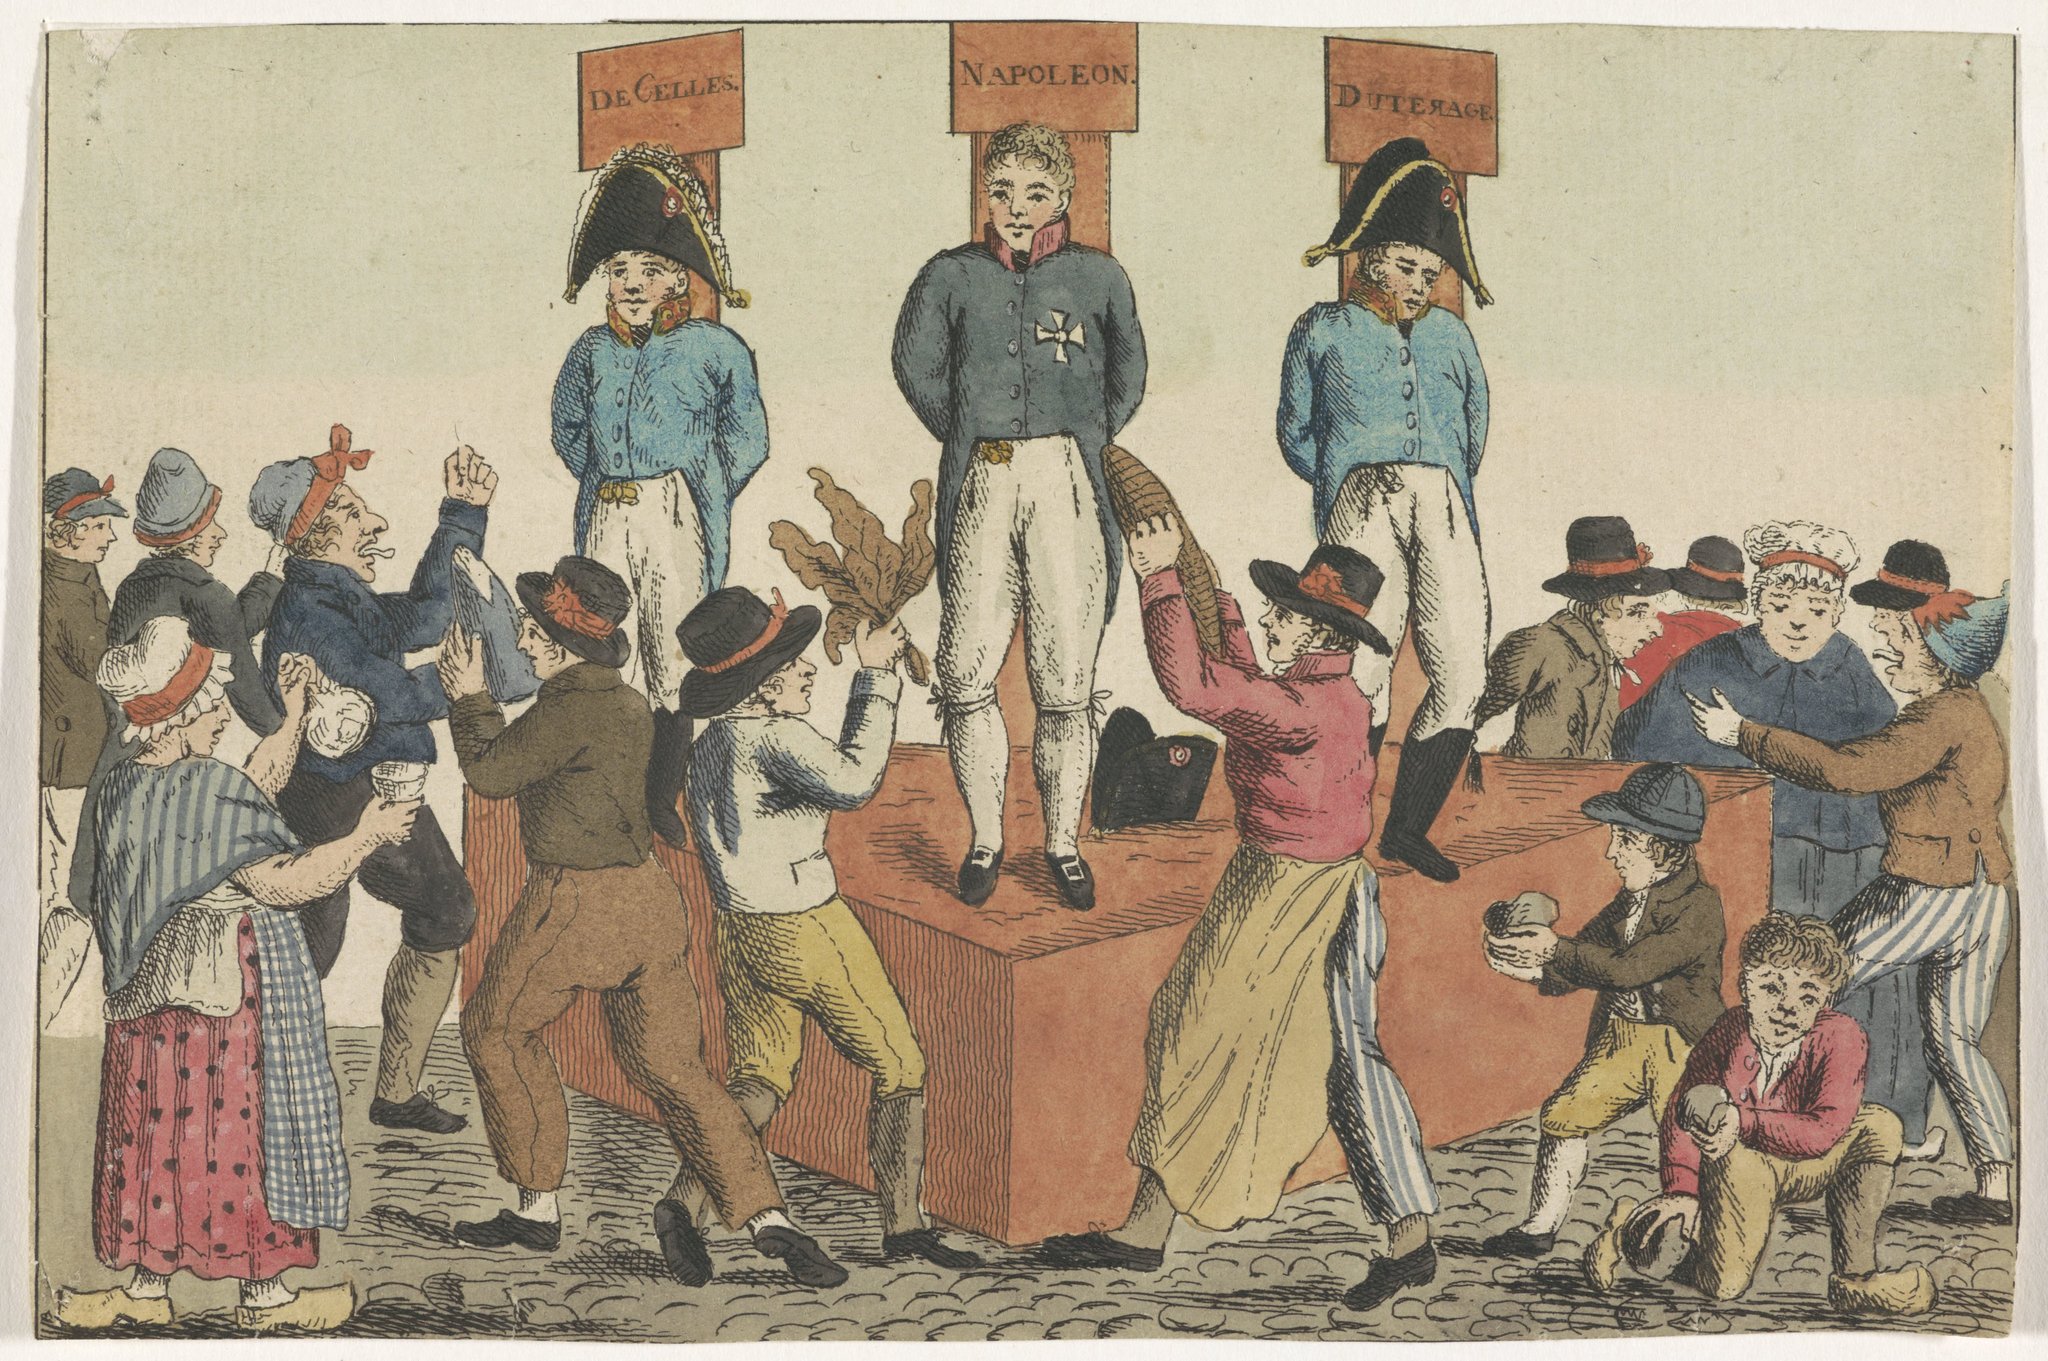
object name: print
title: Napoleon, De Celles en Duterage aan de schandpaal, 1813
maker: Anonymous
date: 1813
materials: paper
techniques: etching, hand coloring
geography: netherlands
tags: napoleon i (emperor of the french), in the pillory, in the stocks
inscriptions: collector's mark: Lugt 2228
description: Spotprent op Napoleon, mogelijk in verband met de afschaffing van accijnzen (regie-tabak en brood?) met het vertrek van de Fransen uit Nederland in 1813. Podium waarop prefect Antoine de Celles, keizer Napoleon en Duterage aan schandpalen gebonden zijn. Zij worden bespot door het publiek dat merendeels hoofddeksels met oranjelinten draagt. Twee mannen in het midden houden tabaksbladeren en een brood omhoog, enkele jongens rapen stenen van de straat.